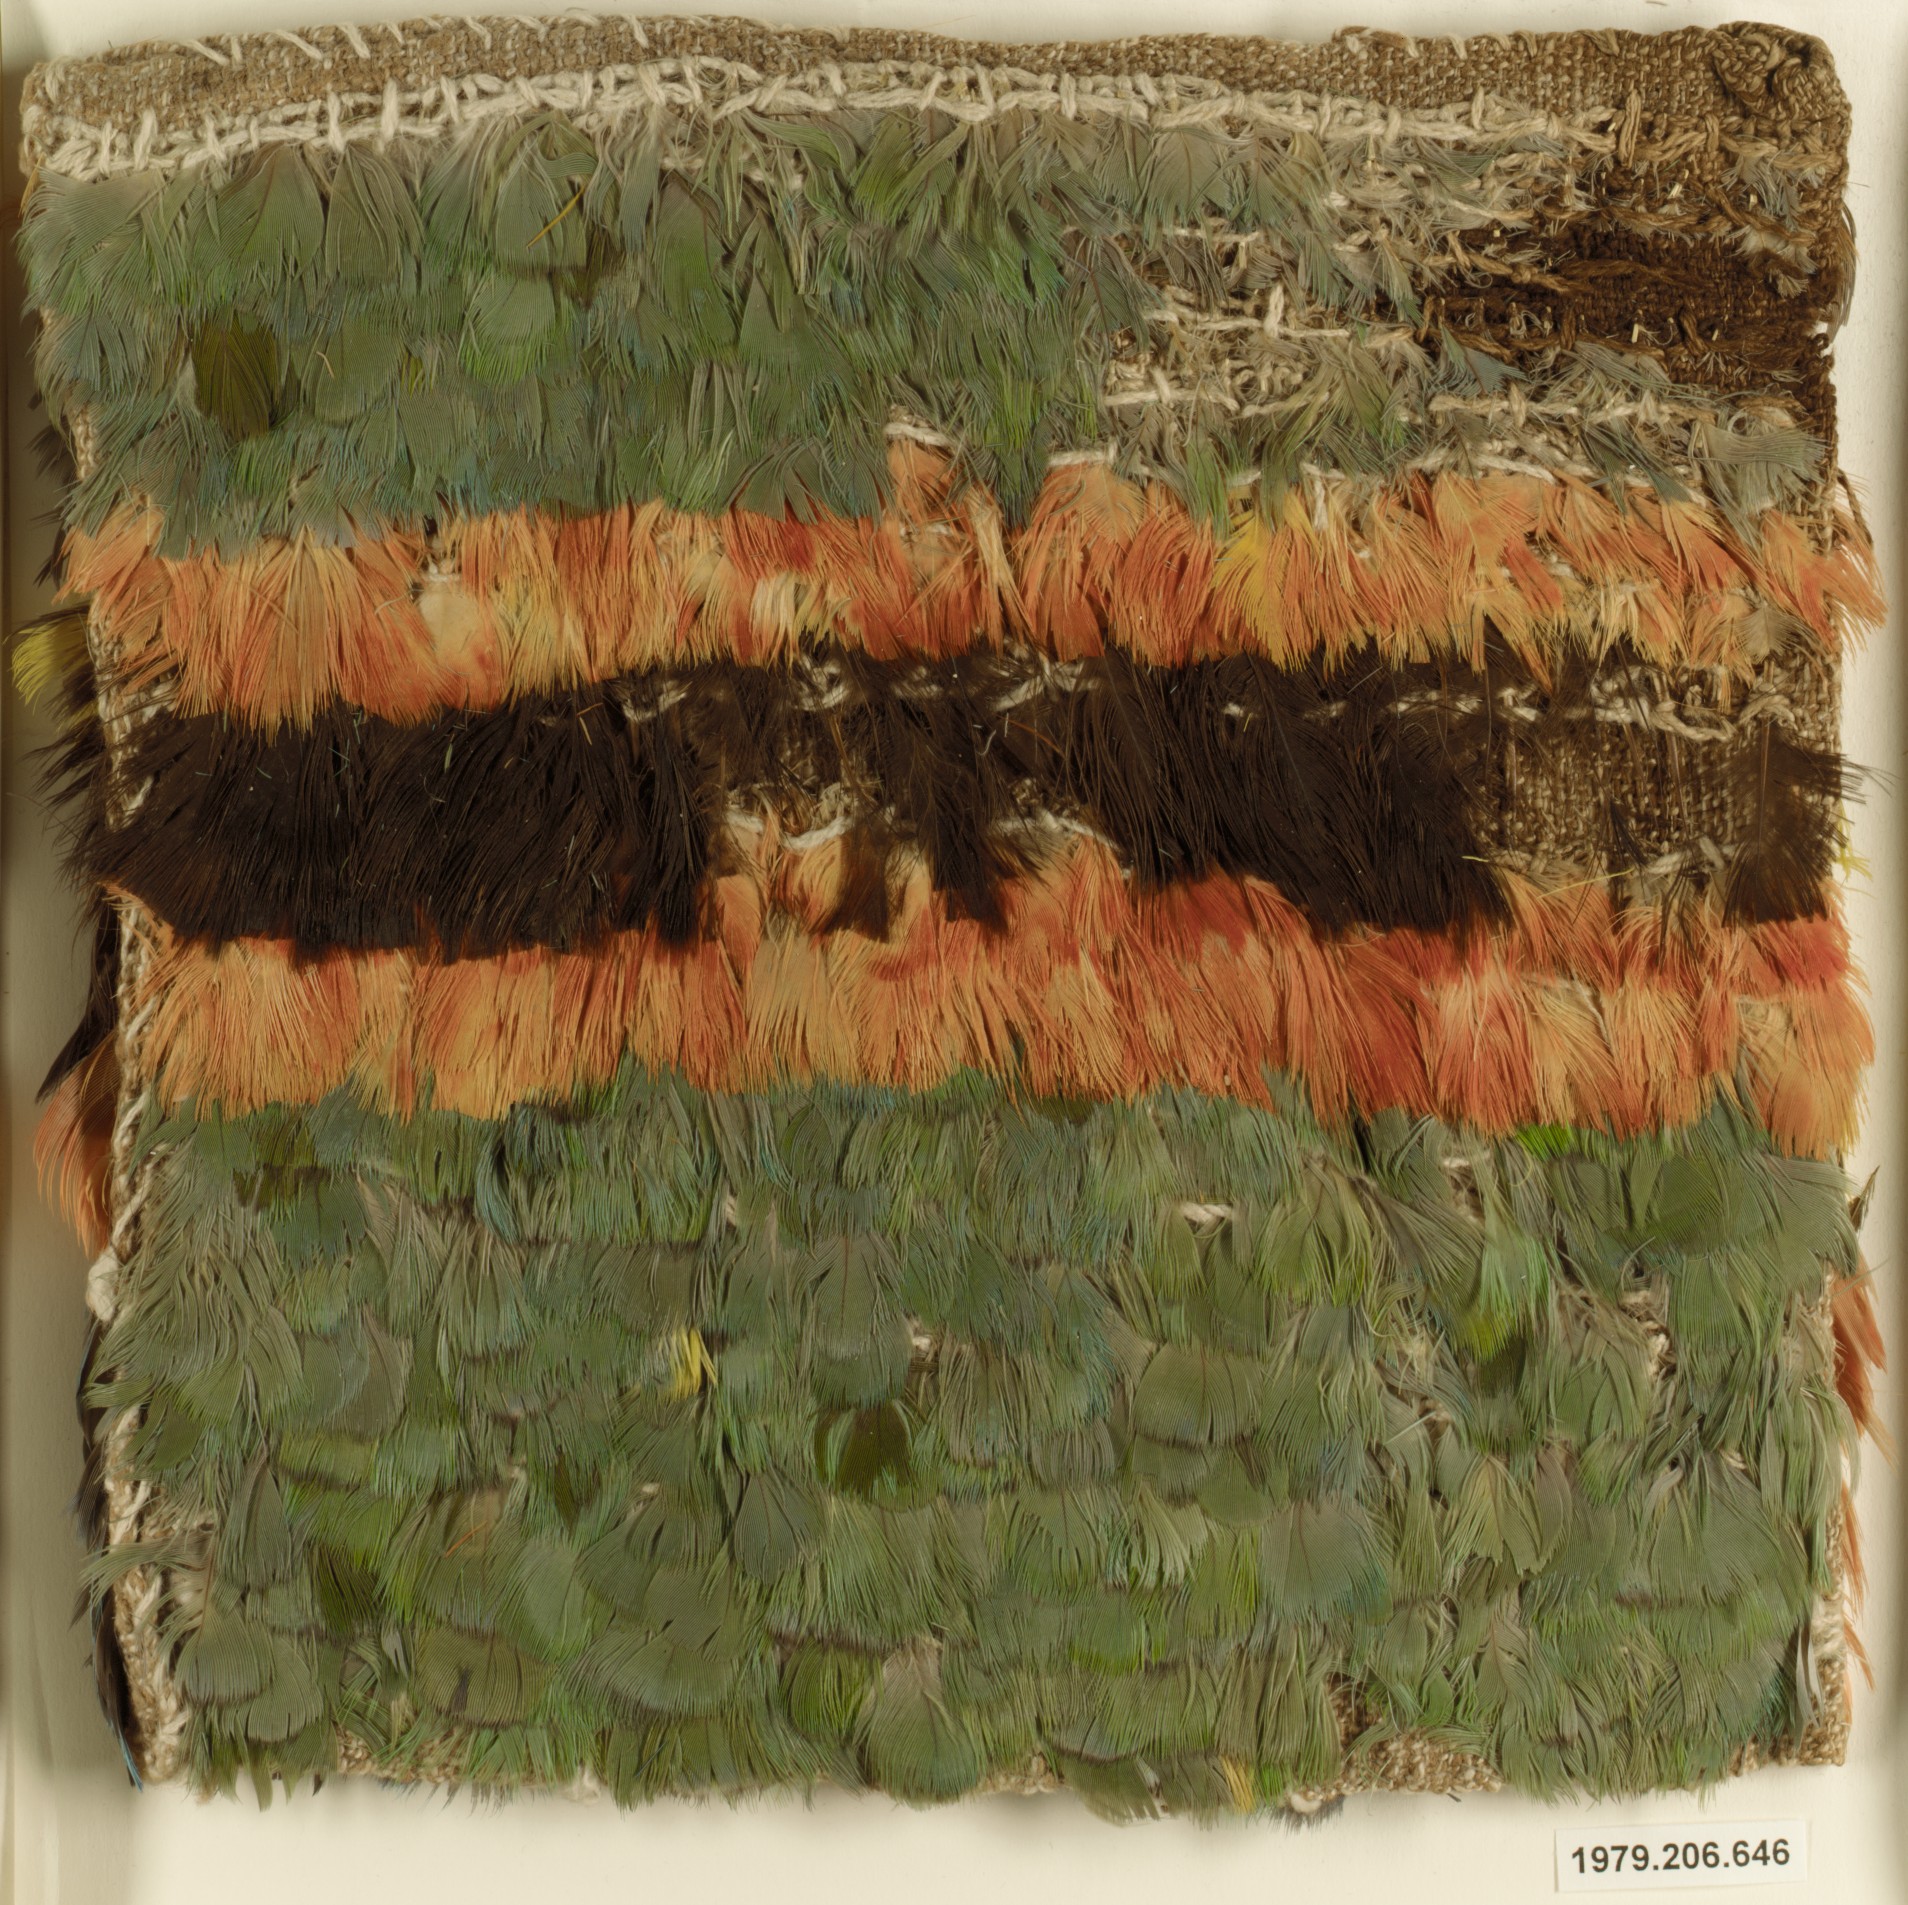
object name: miniature dress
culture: ica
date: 1101-1300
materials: cotton, feather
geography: peru